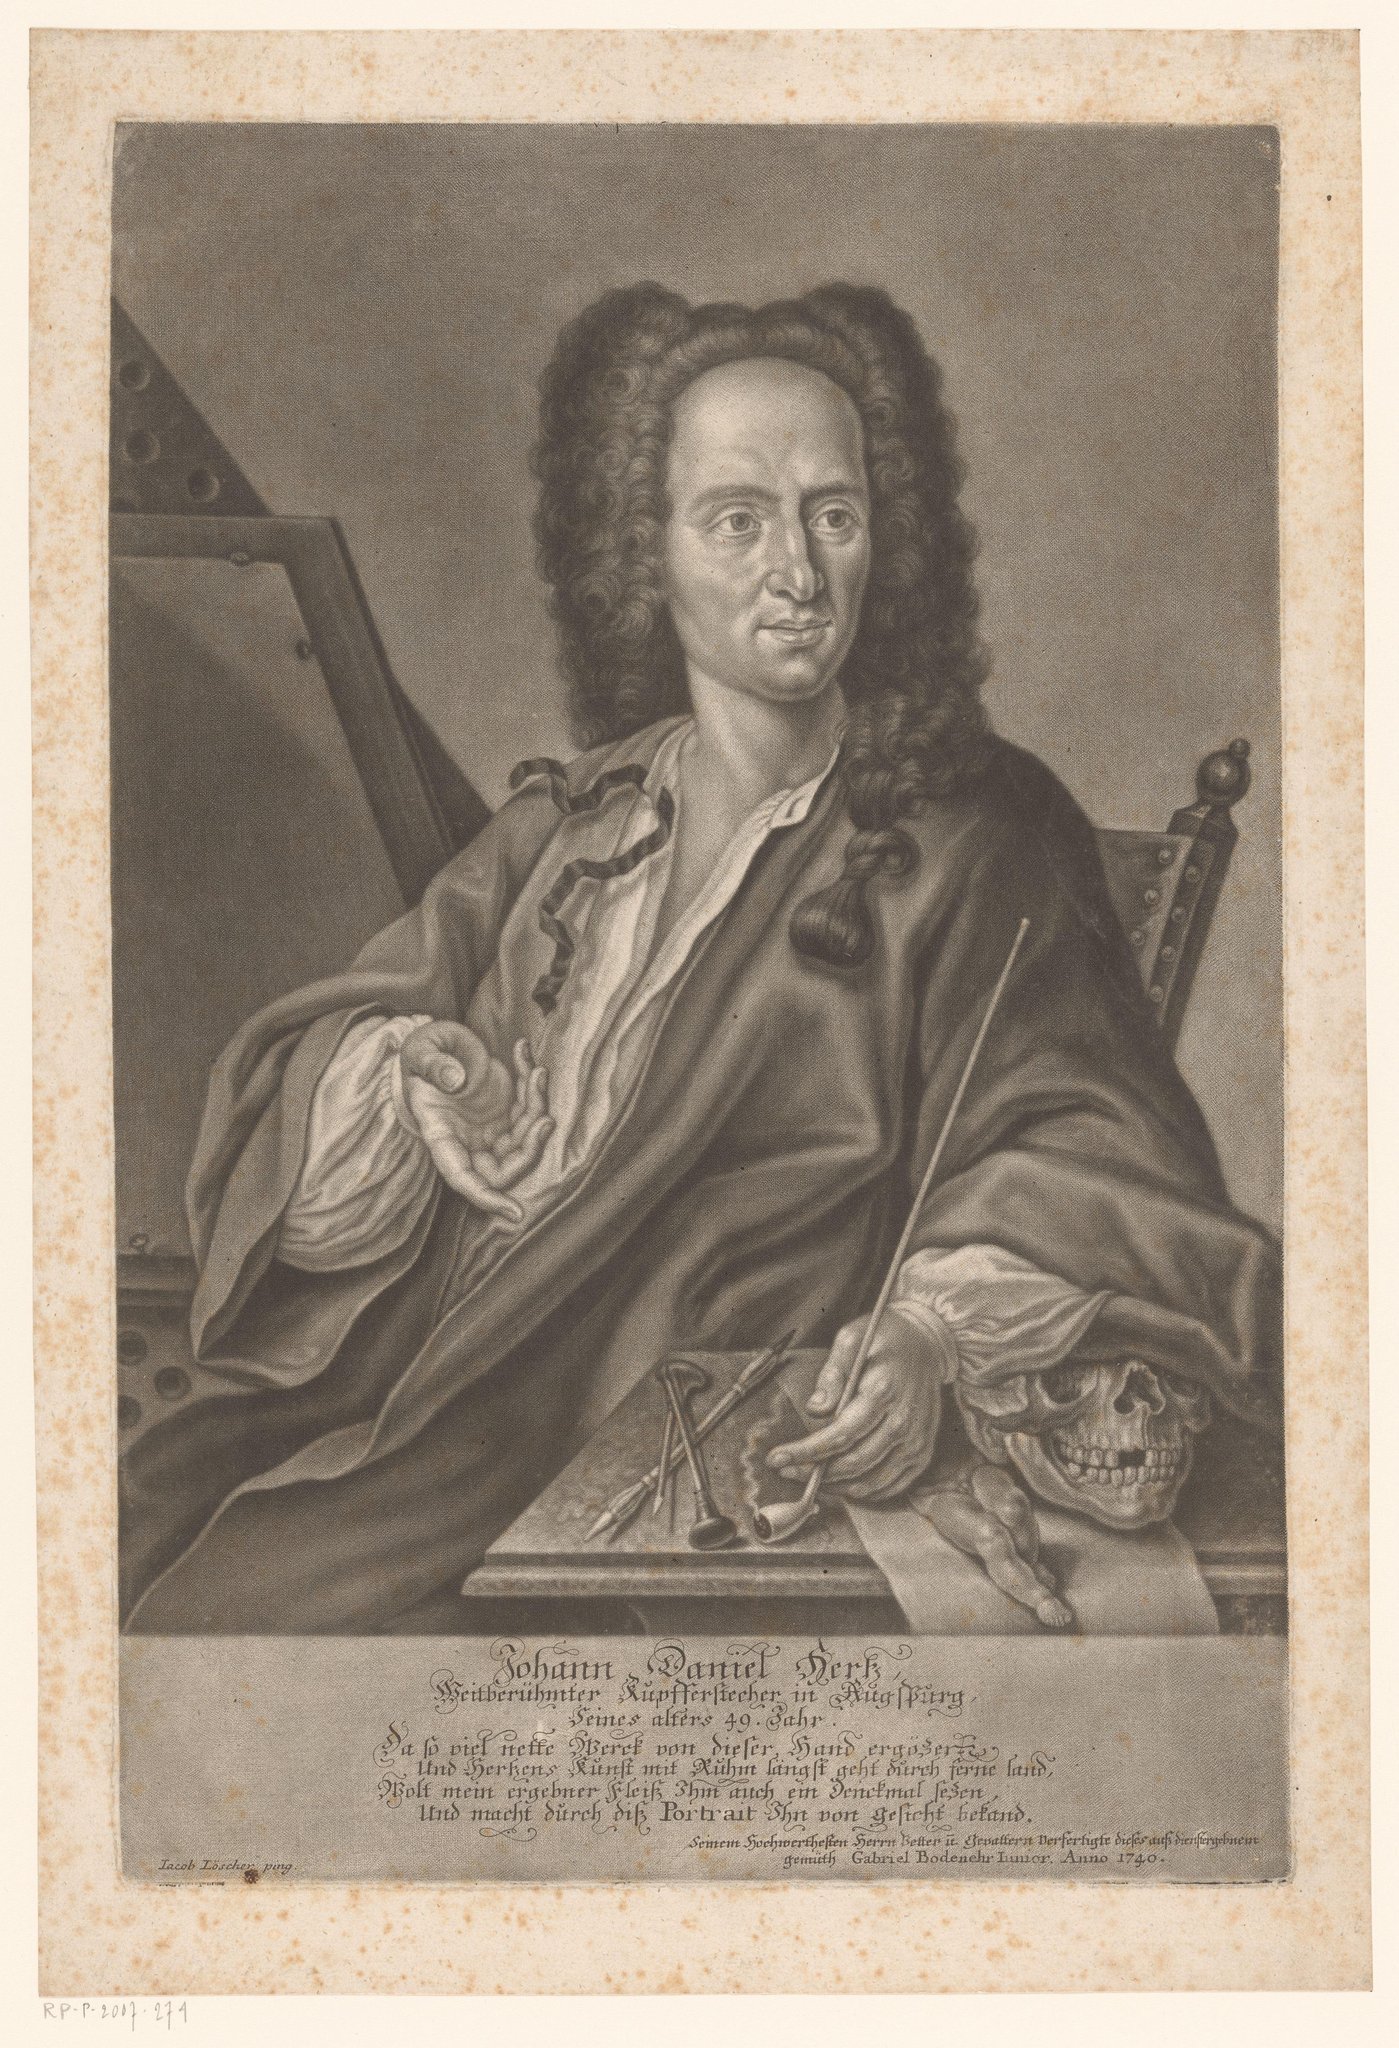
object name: print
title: Portret van Johann Daniel Herz op 49-jarige leeftijd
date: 1740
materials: paper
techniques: mezzotint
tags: augsburg, print maker, publisher, johann daniel herz (i), tools, implements of graphic artist (with name), pipe ~ tobacco, tools, implements of graphic artist, skull as symbol of 'vanitas', portrait, self-portrait of graphic artist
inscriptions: collector's mark: Lugt 2228, collector's mark: Lugt 2760